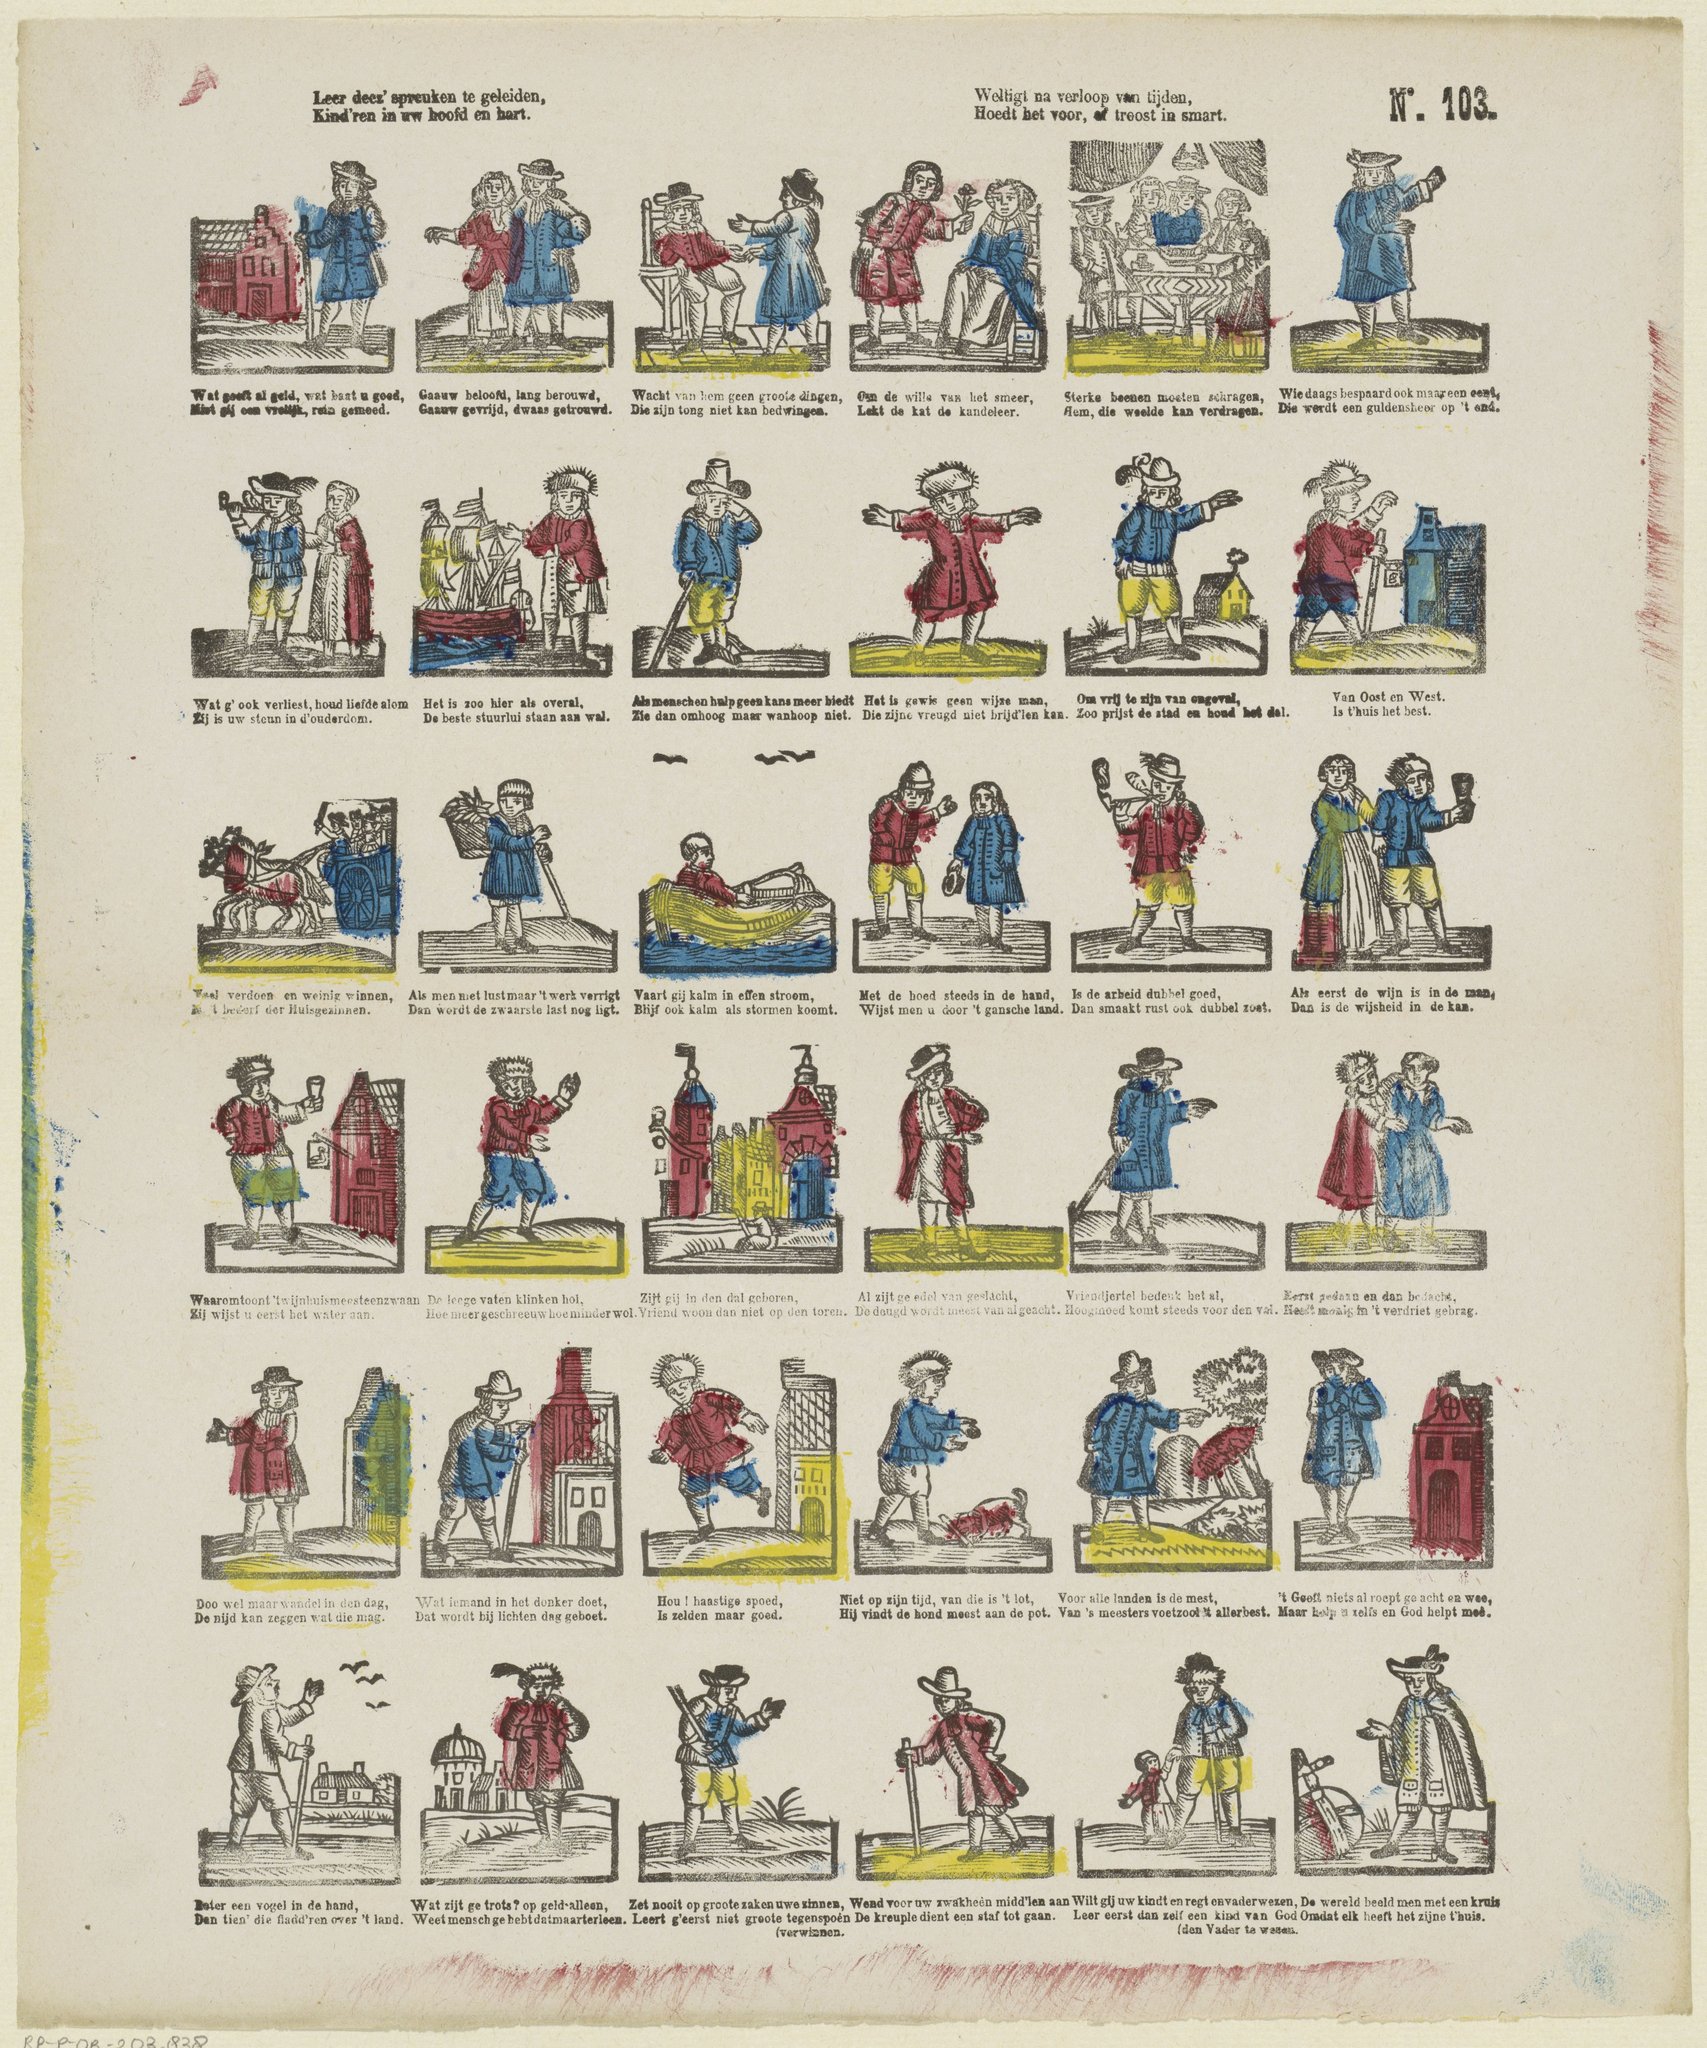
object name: print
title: Leer deez' spreuken te geleiden, / Kind'ren in uw hoofd en hart / Welligt na verloop van tijden, / Hoedt het voor, of troost in smart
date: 1827-1894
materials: paper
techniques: colour, letterpress printing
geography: schaarbeek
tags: proverbs, sayings, etc.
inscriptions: collector's mark: Lugt 2760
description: Blad met 36 verbeeldingen van spreekwoorden en gezegden. Onder elke afbeelding een tweeregelig vers. Genummerd rechtsboven: No. 103.